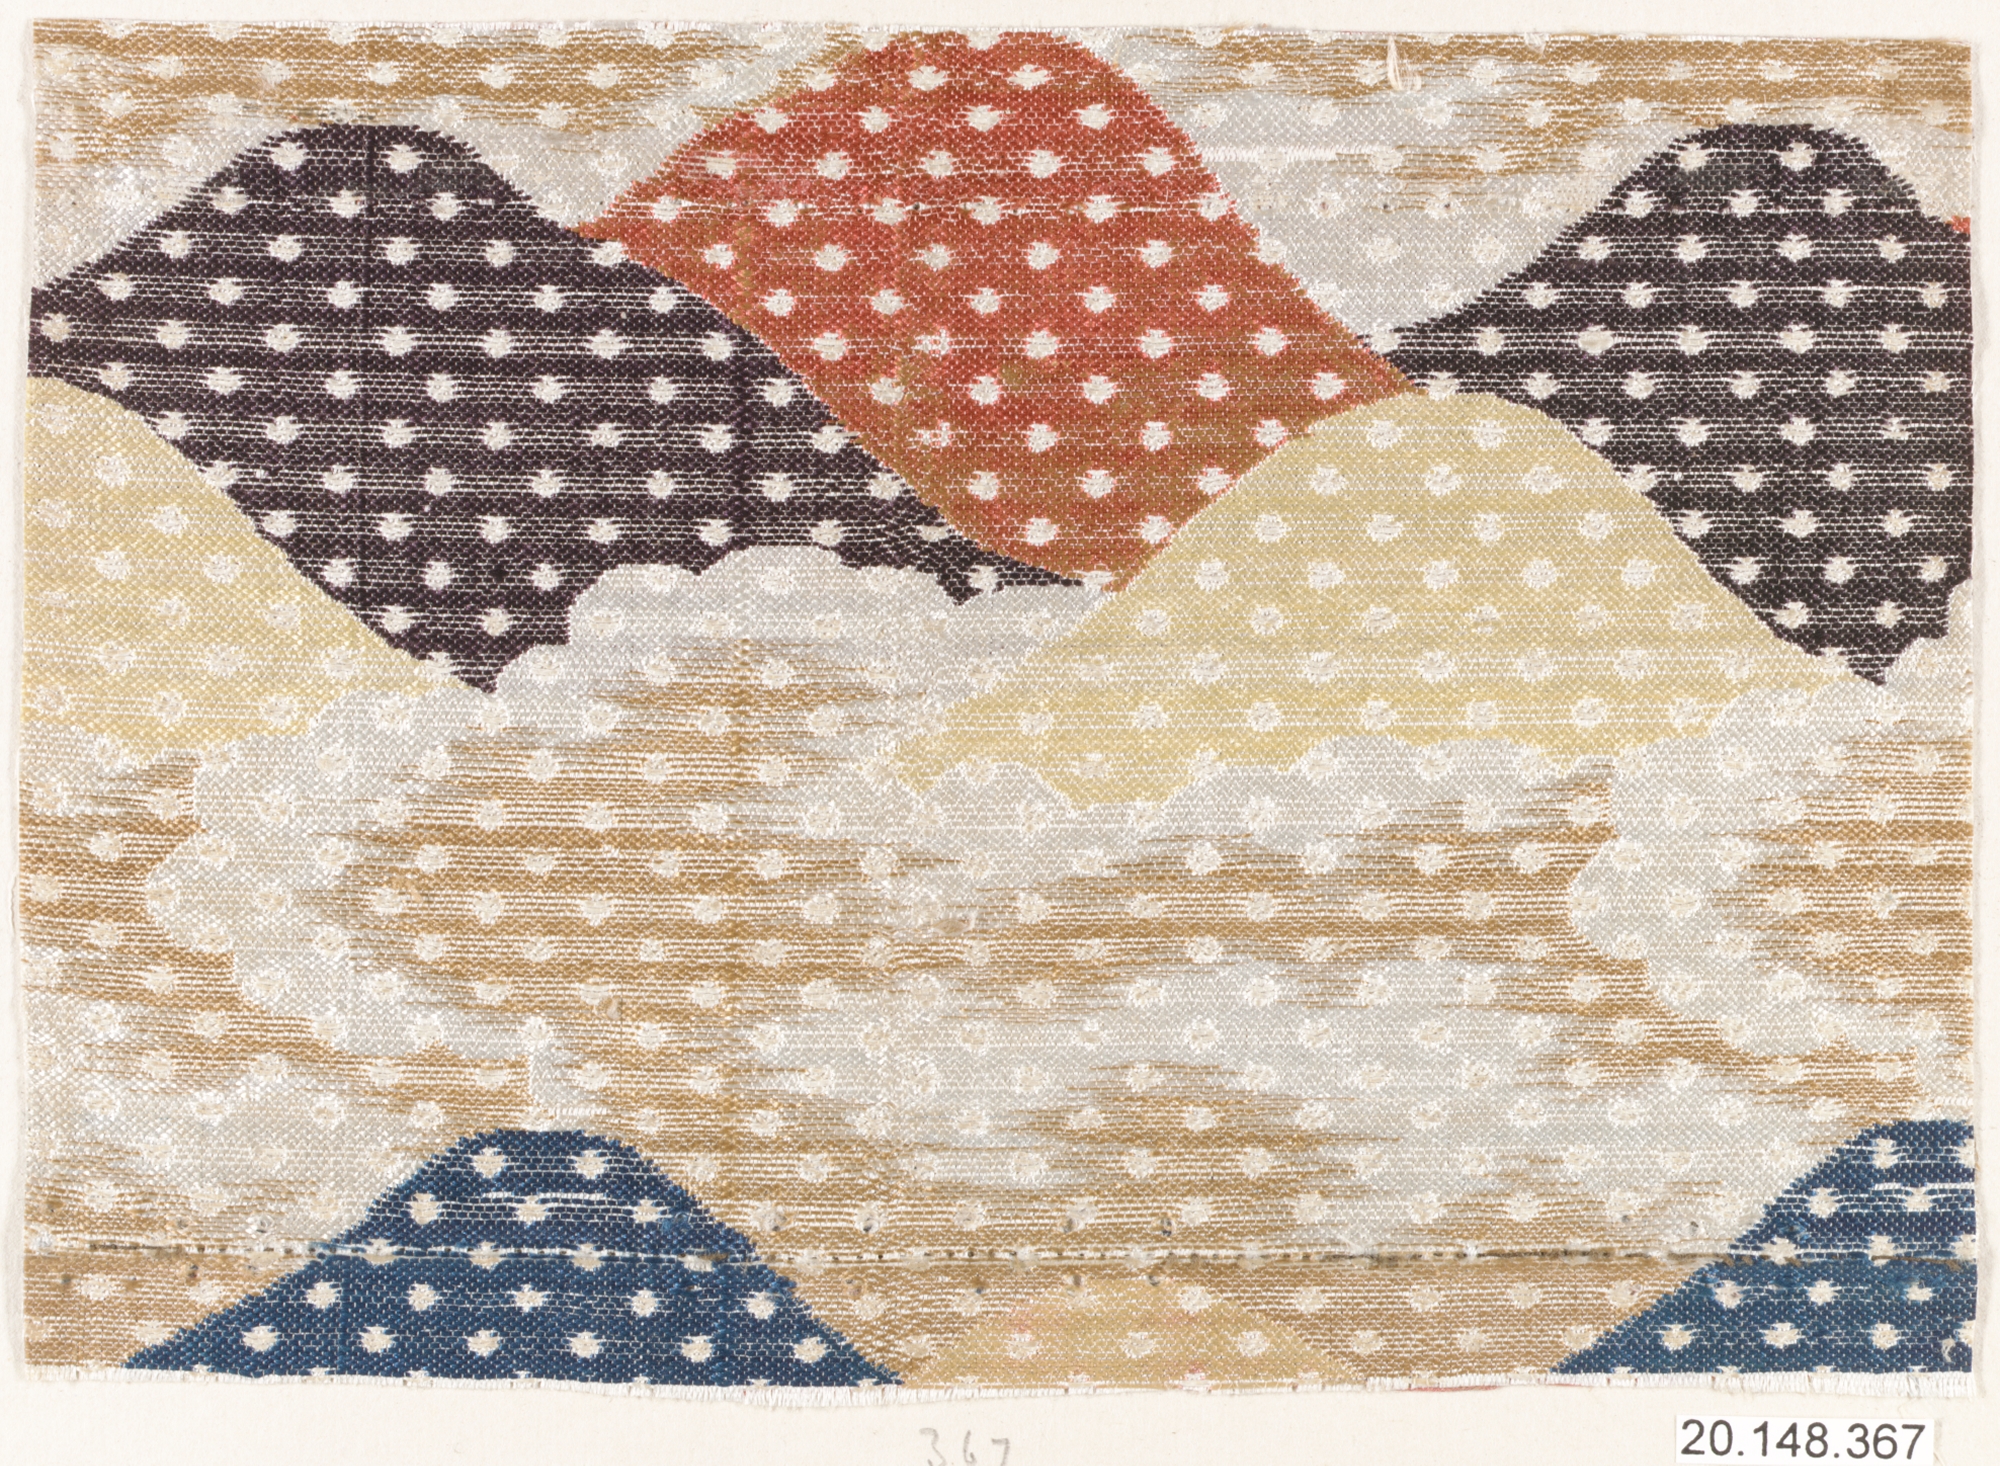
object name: piece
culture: japanese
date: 1701-1800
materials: silk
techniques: compound weave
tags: hills